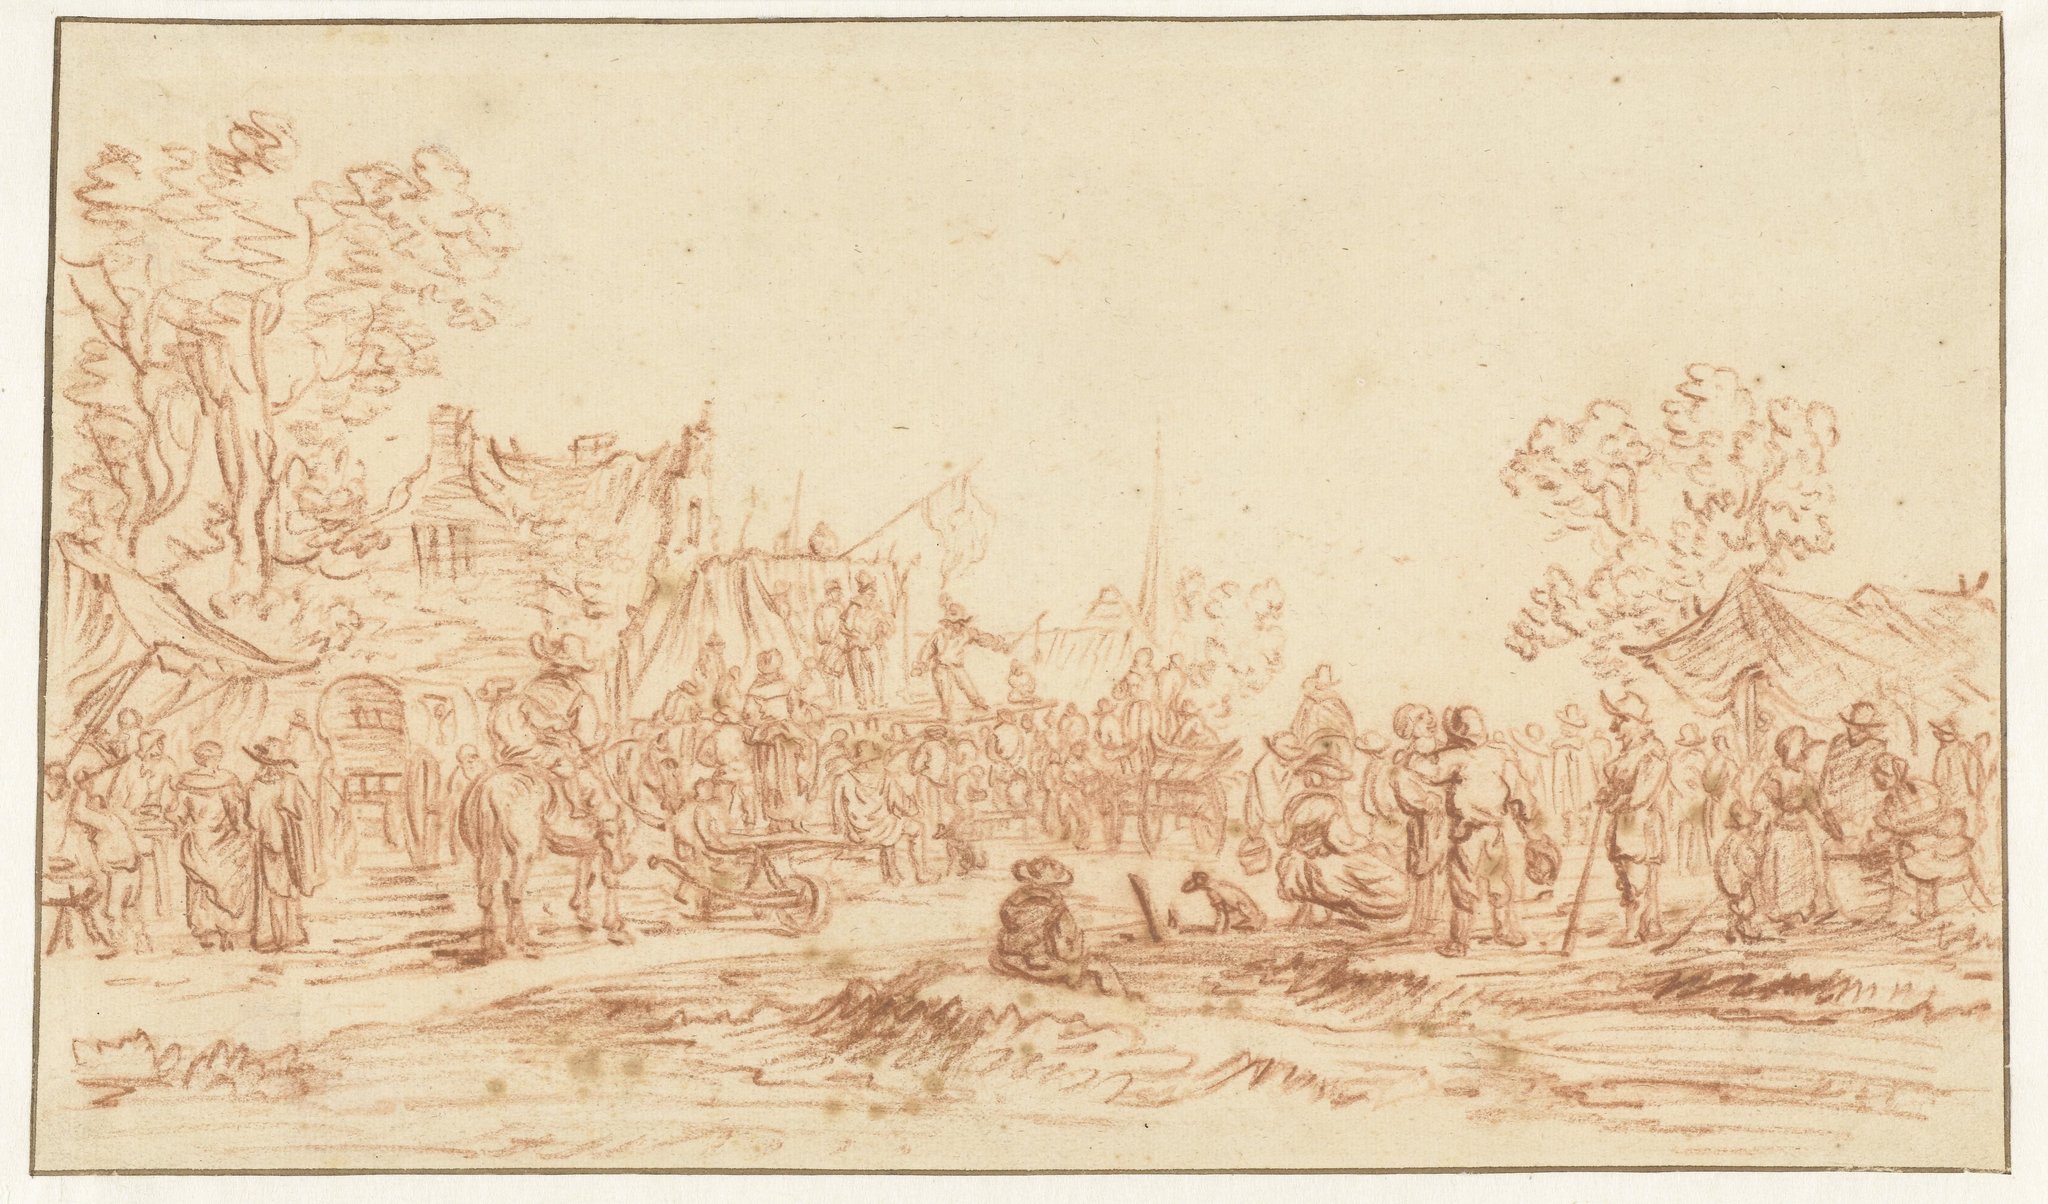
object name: drawing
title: Kermis in een dorp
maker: Anonymous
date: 1653-1700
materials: chalk, paper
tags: group of actors, troupe; actors on the stage, (annual) fair, trade fair, public road in village